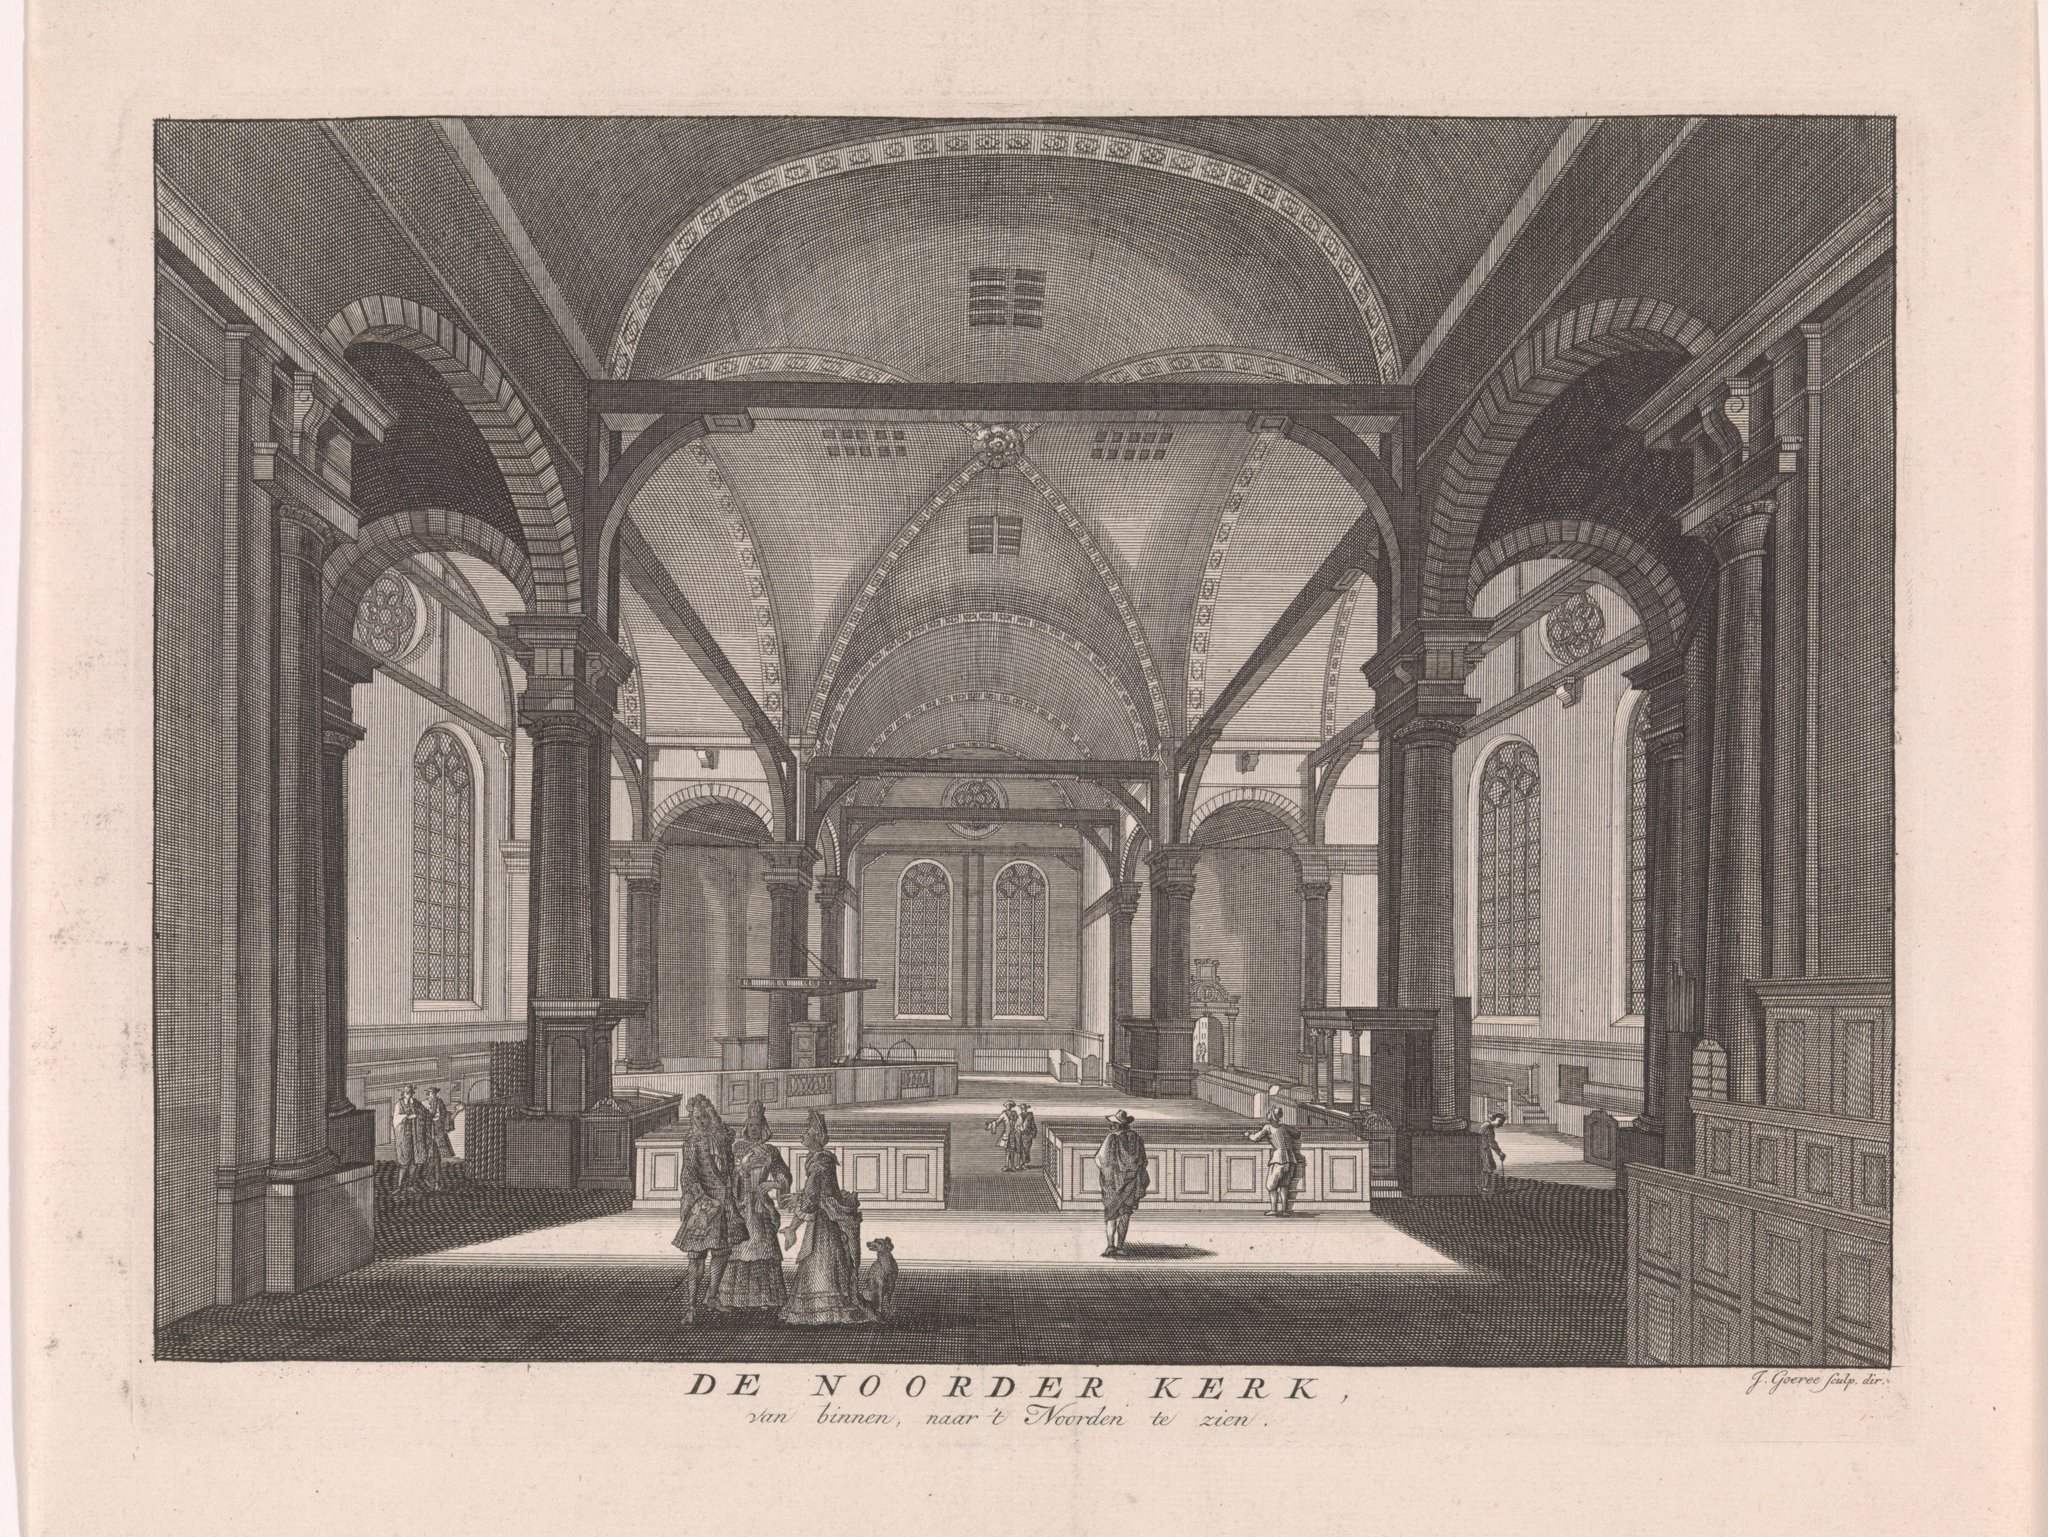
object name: print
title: De Noorder Kerk, van binnen, naar 't Noorden te zien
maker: jan goeree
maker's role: draughtsman, print maker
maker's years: 1670-1731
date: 1680-1731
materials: paper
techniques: engraving, etching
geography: amsterdam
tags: parts of church interior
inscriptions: collector's mark: Lugt 2228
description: Mogelijk uit Verzameling der fraaiste Gezigten van Amsterdam in negenenzeventig afbeeldingen. Amsterdam en Harlingen: bij Petrus Conrad en V. van der Plaats, 1782.